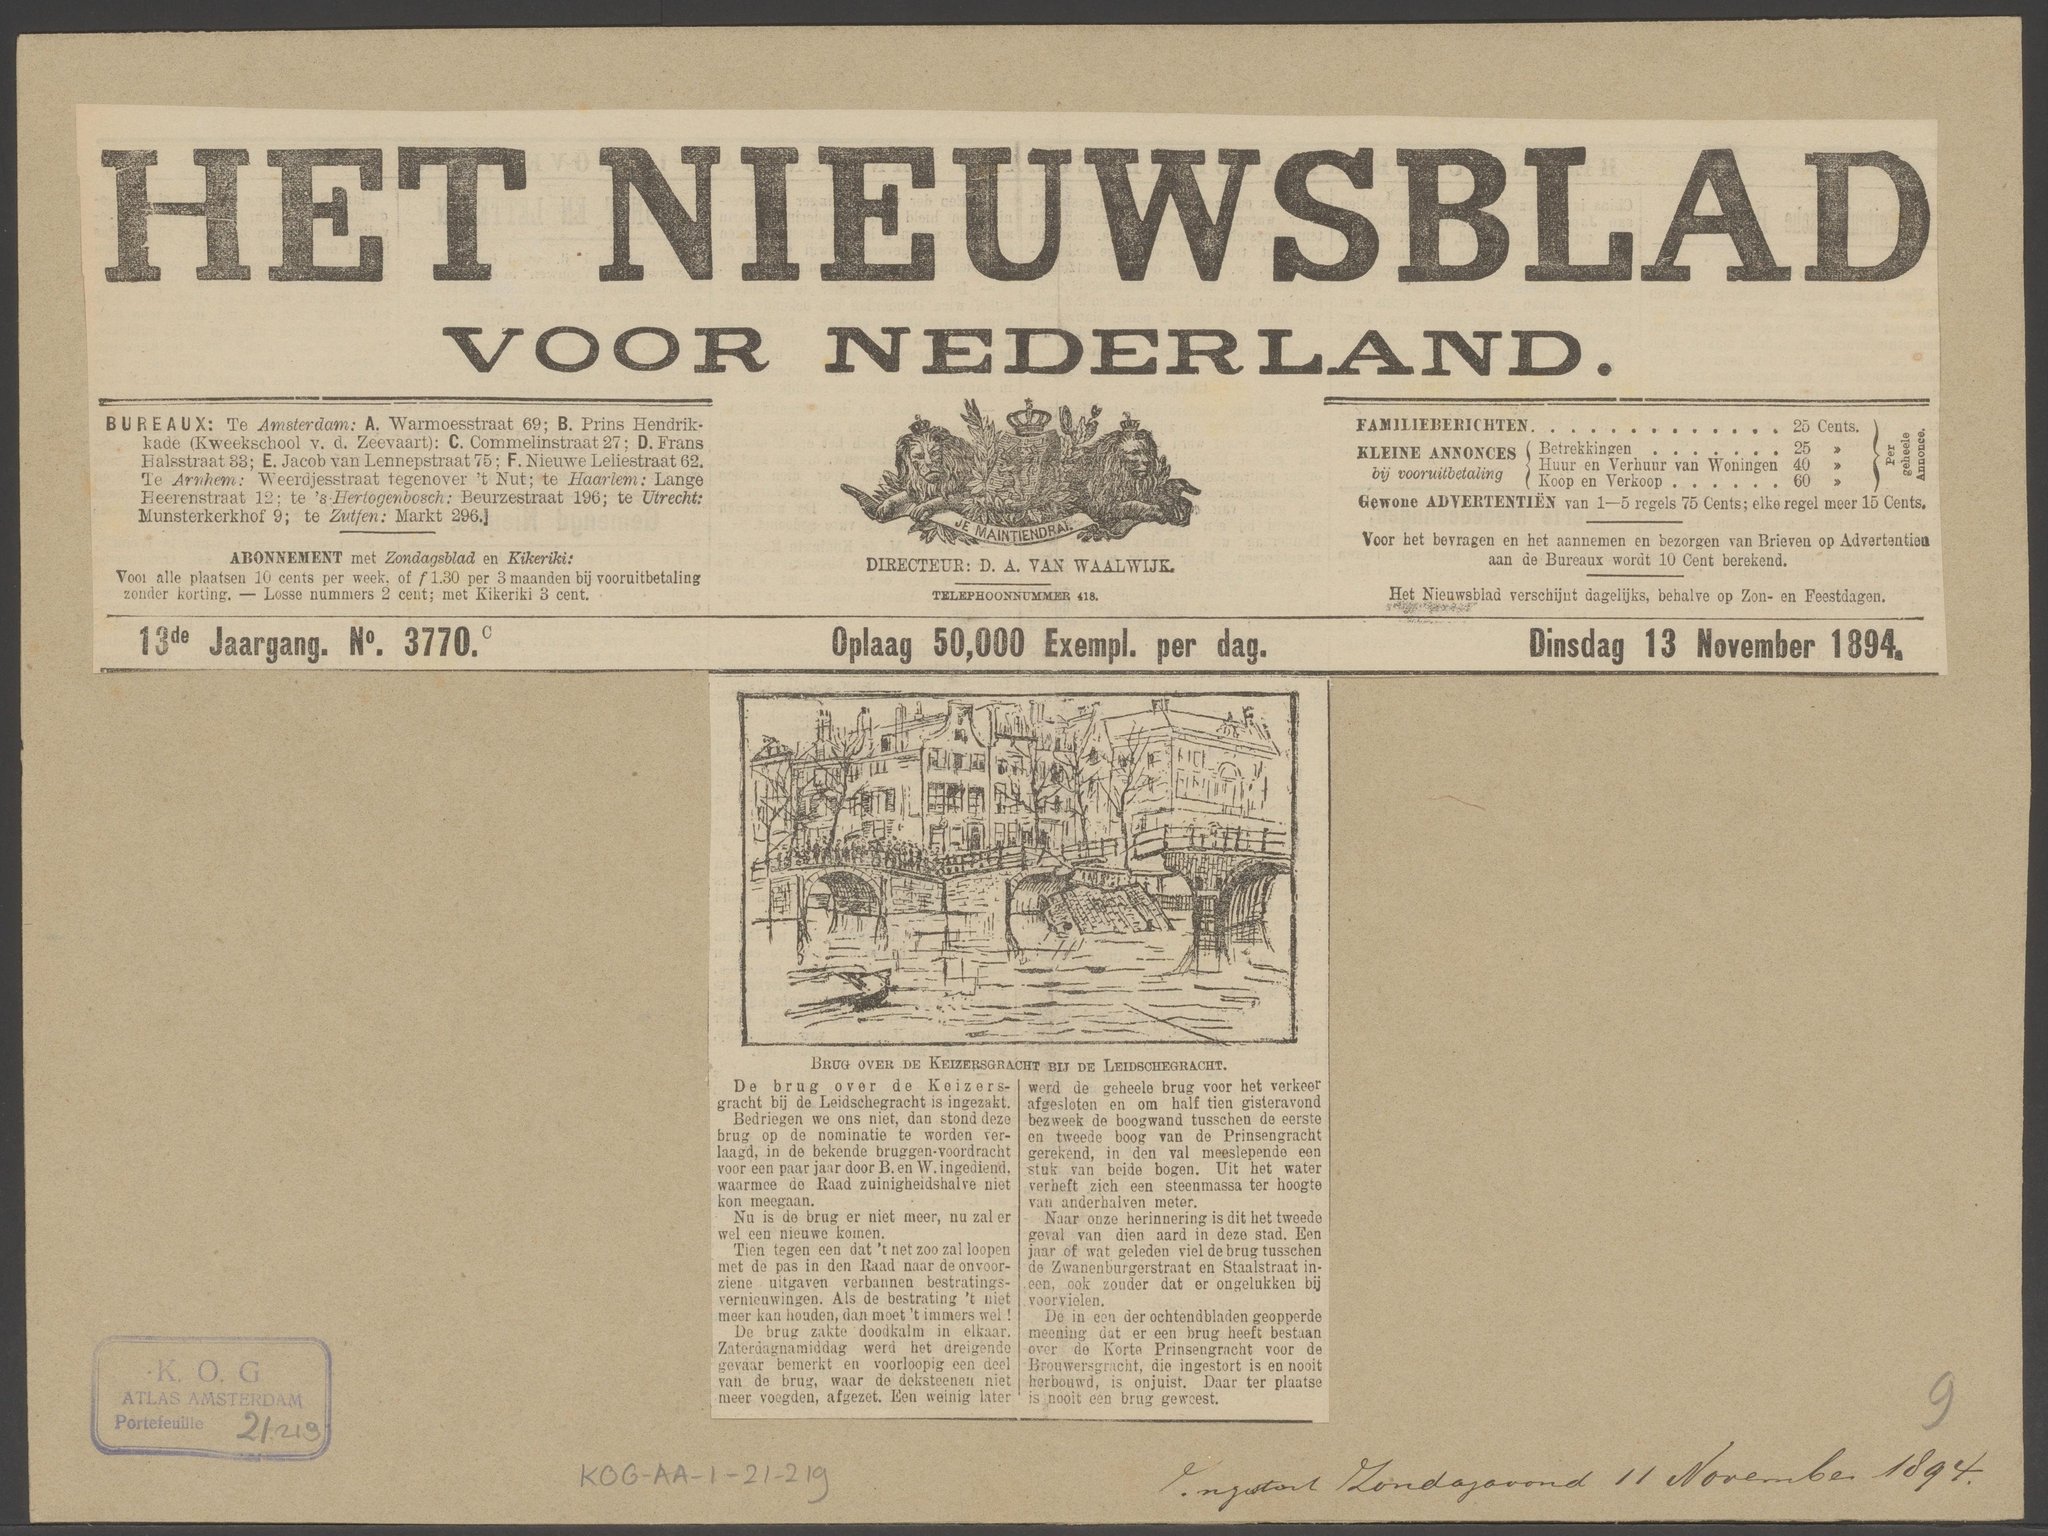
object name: newspaper clipping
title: Titelpagina voor: Het Nieuwsblad voor Nederland, 13 november 1894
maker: Anonymous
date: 1894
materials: paper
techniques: letterpress printing, line block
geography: netherlands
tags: city-view, and landscape with man-made constructions, canals, waters (in city), collapsing building, bridge in city across river, canal, etc.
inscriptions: collector's mark: Lugt 1641b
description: Titelpagina voor: Het Nieuwsblad voor Nederland 13 (1894), nr. 3370, 13 november 1894.